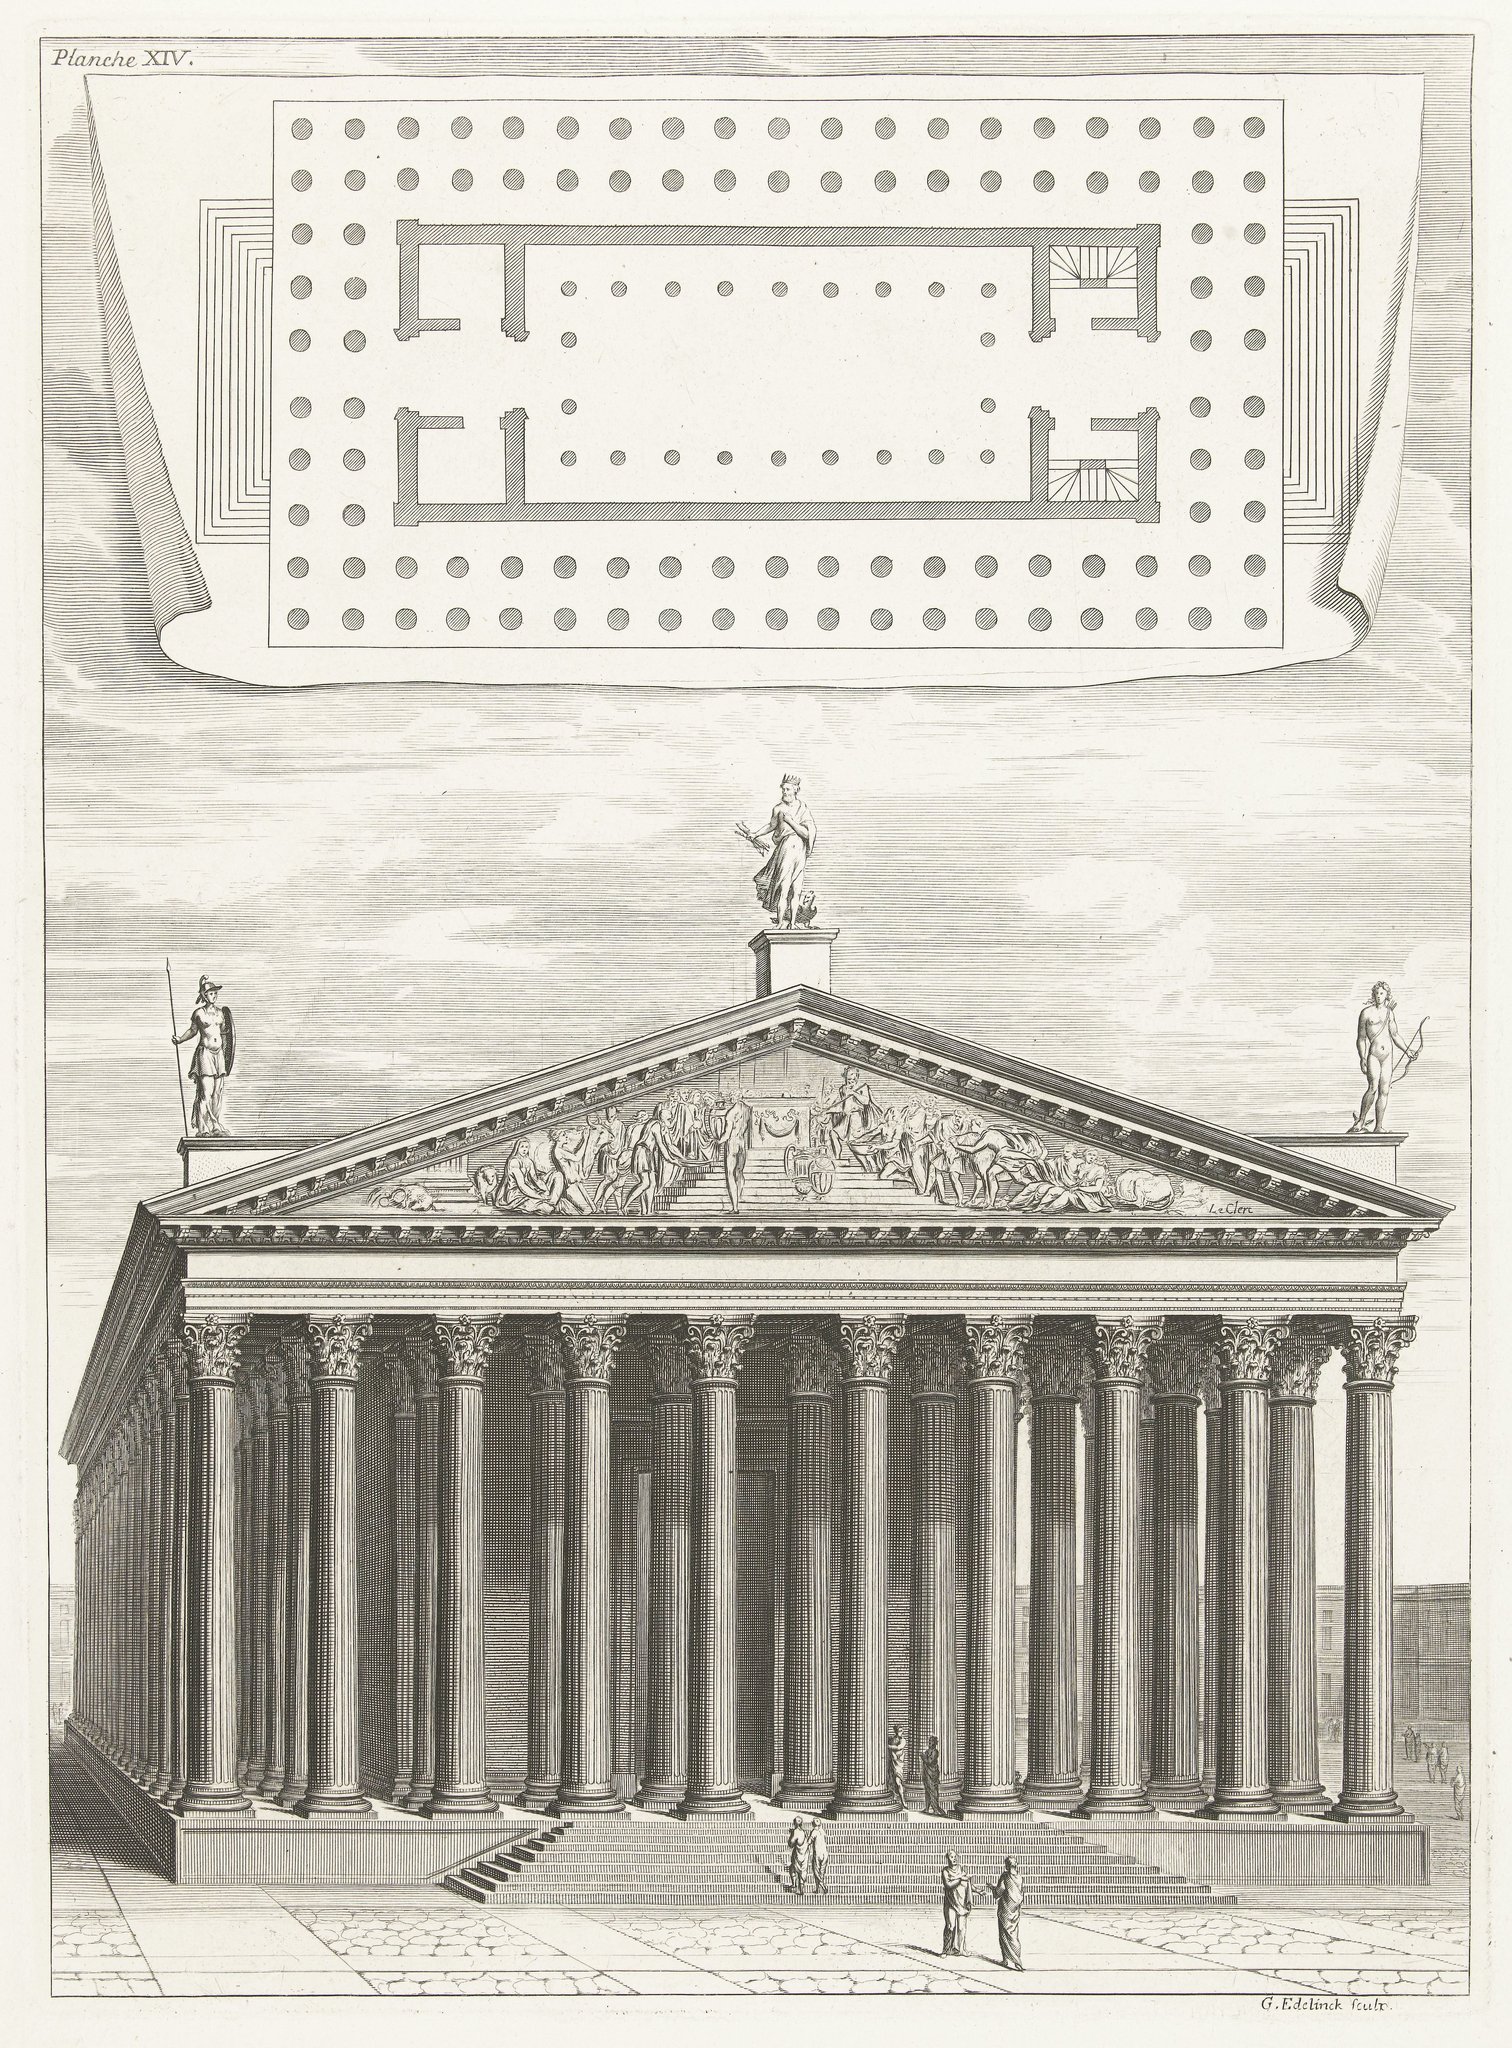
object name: print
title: Tempel van Jupiter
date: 1652-1707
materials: paper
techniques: engraving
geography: paris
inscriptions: collector's mark: Lugt 1695, collector's mark: Lugt 2228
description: Plattegrond en aanzicht van de Jupiter Olympus tempel te Athene.